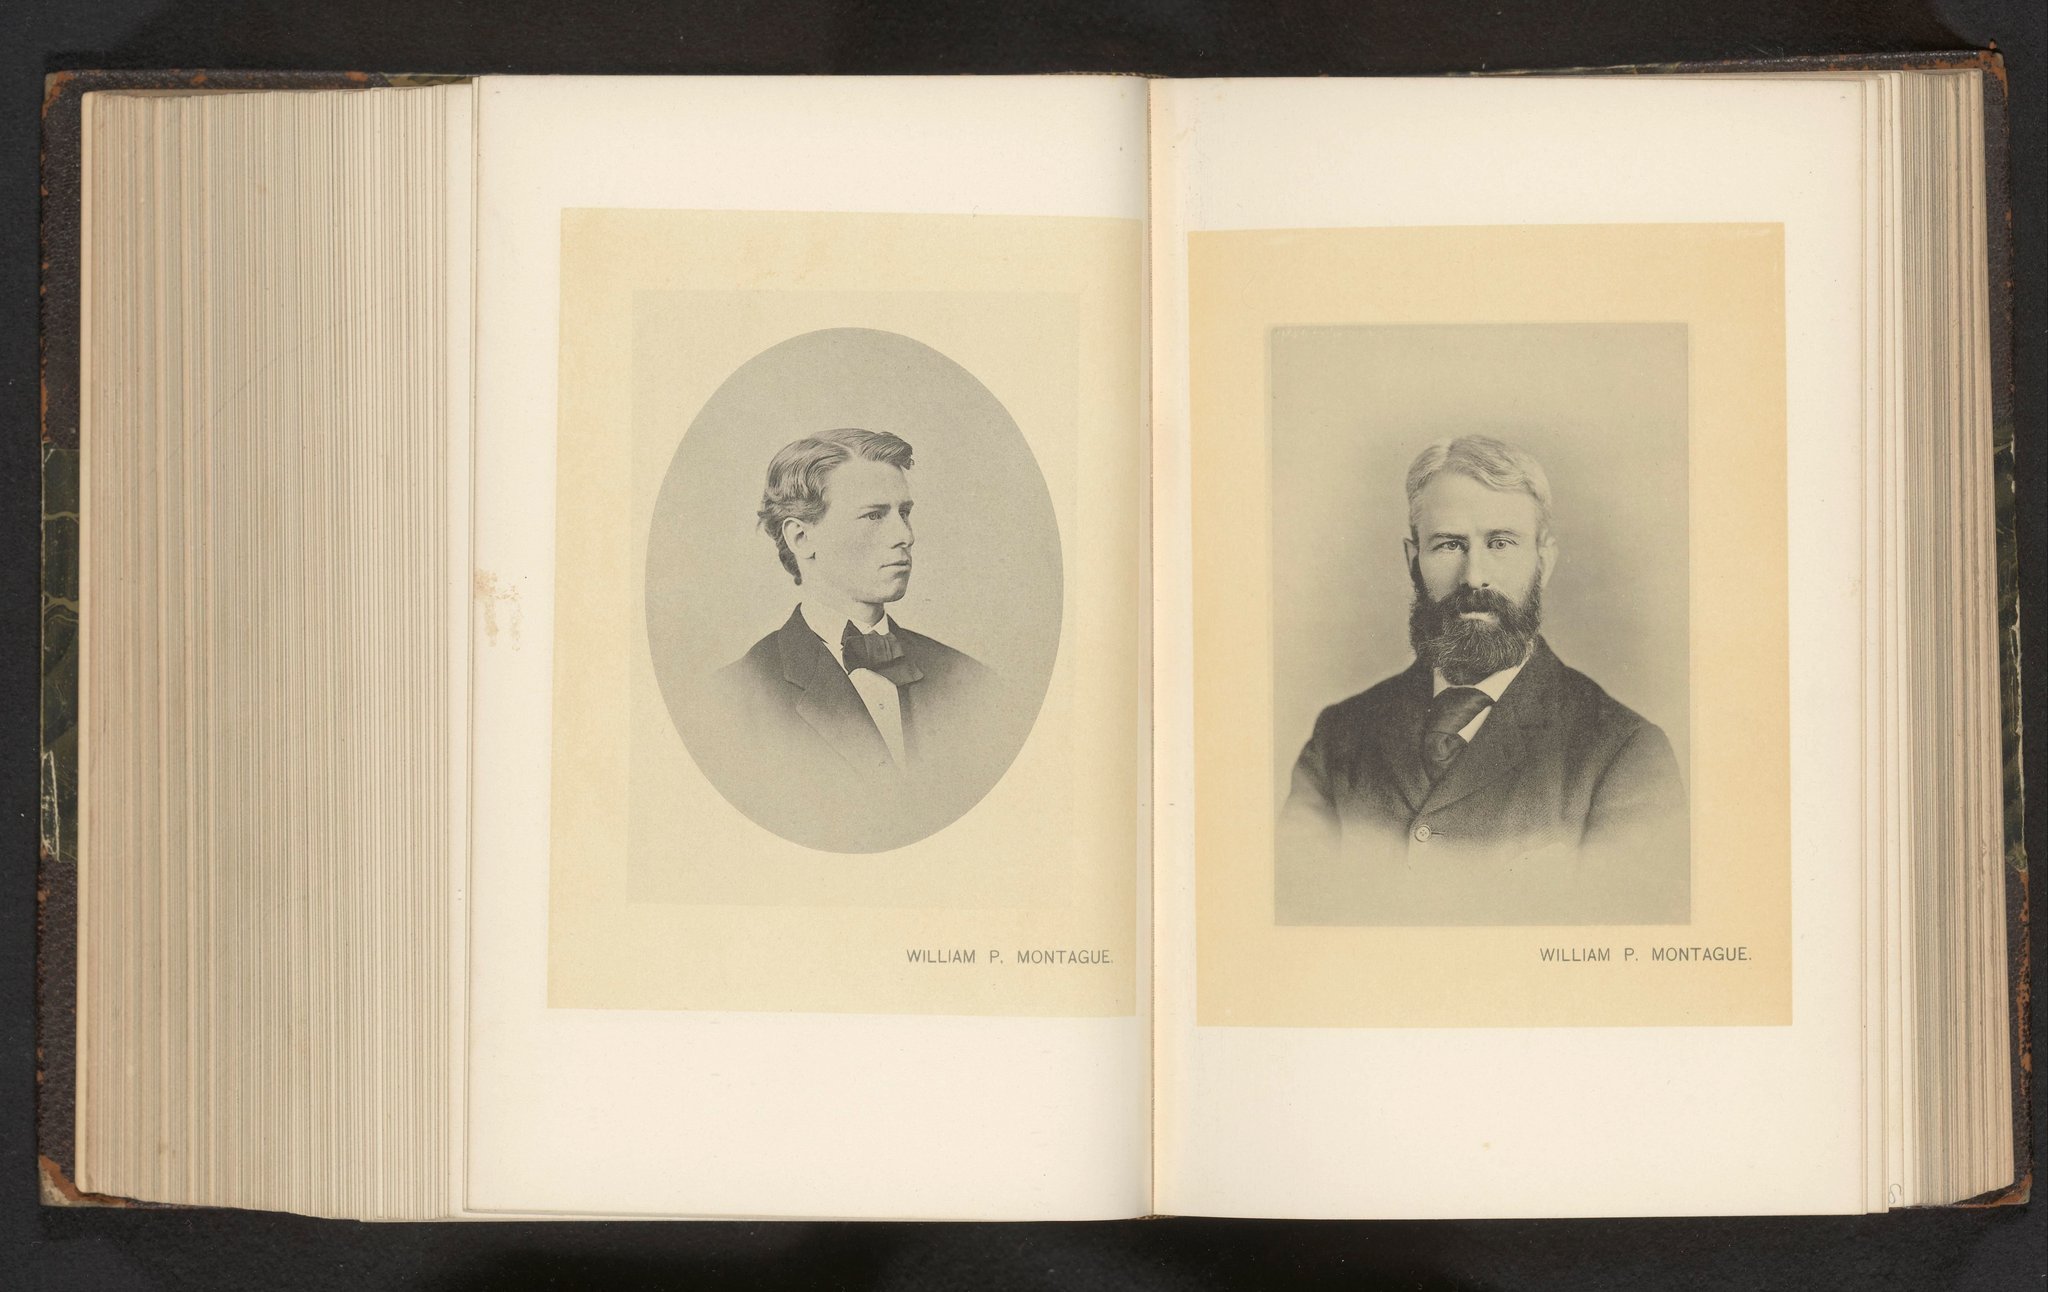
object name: photomechanical print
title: William P. Montague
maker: Anonymous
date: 1889-1894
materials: paper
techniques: photoaquatint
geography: boston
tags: adult man